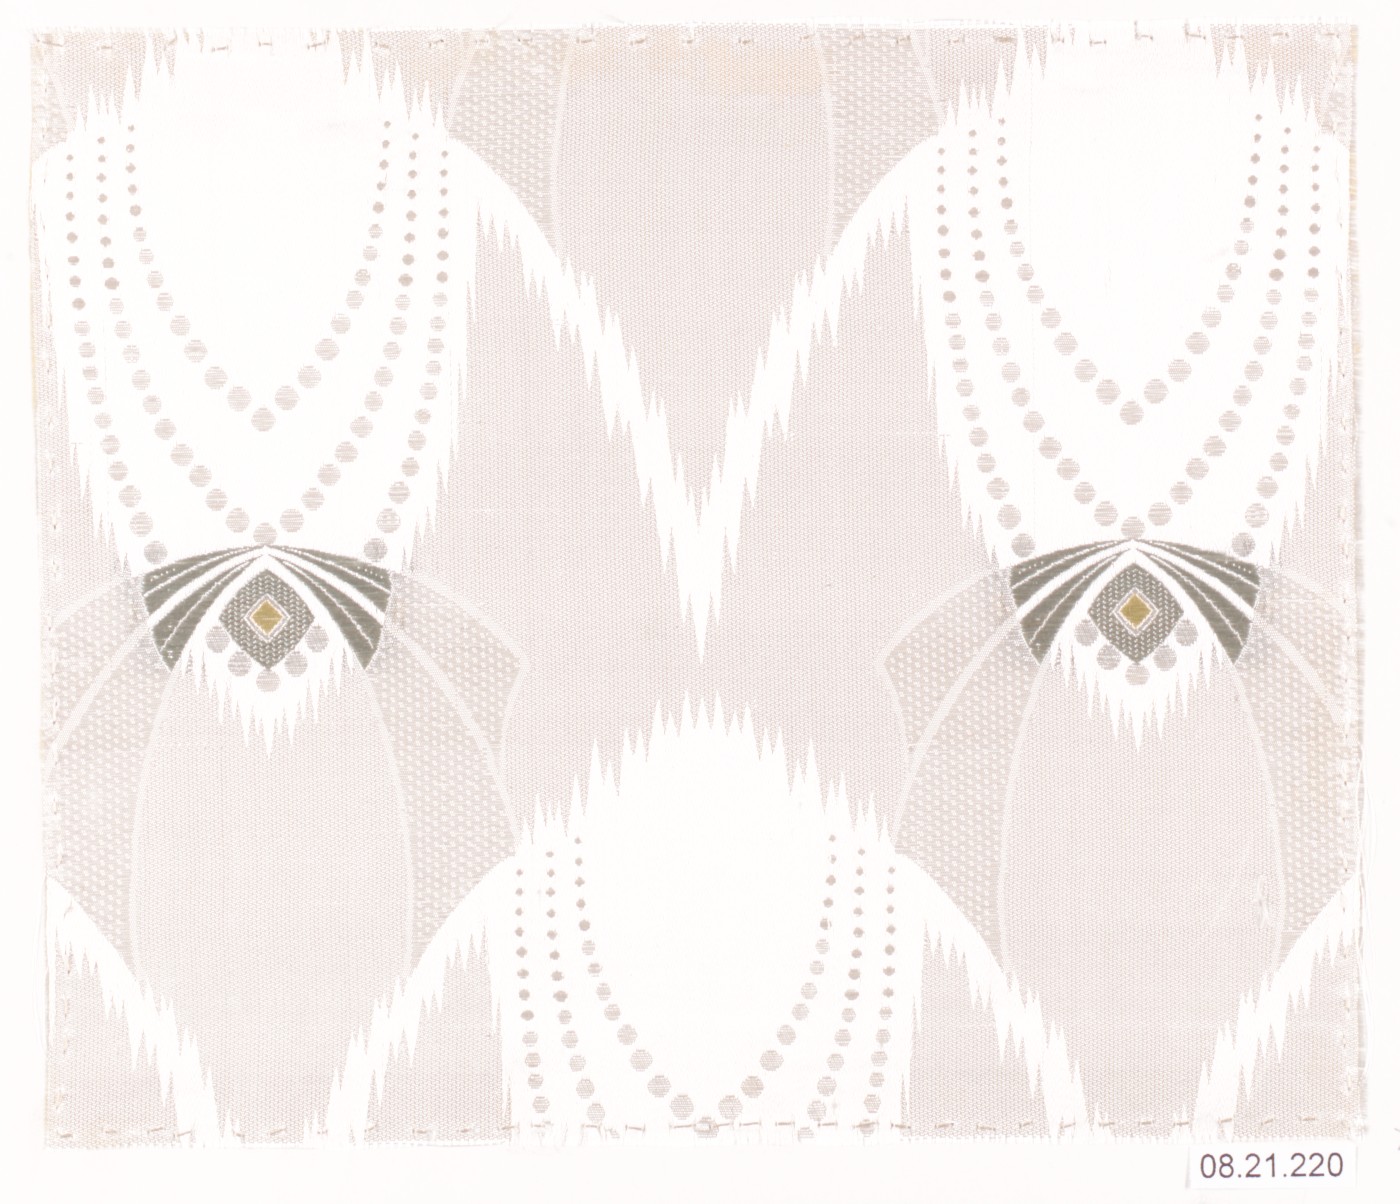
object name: textile sample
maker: Anonymous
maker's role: designer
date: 1900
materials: silk